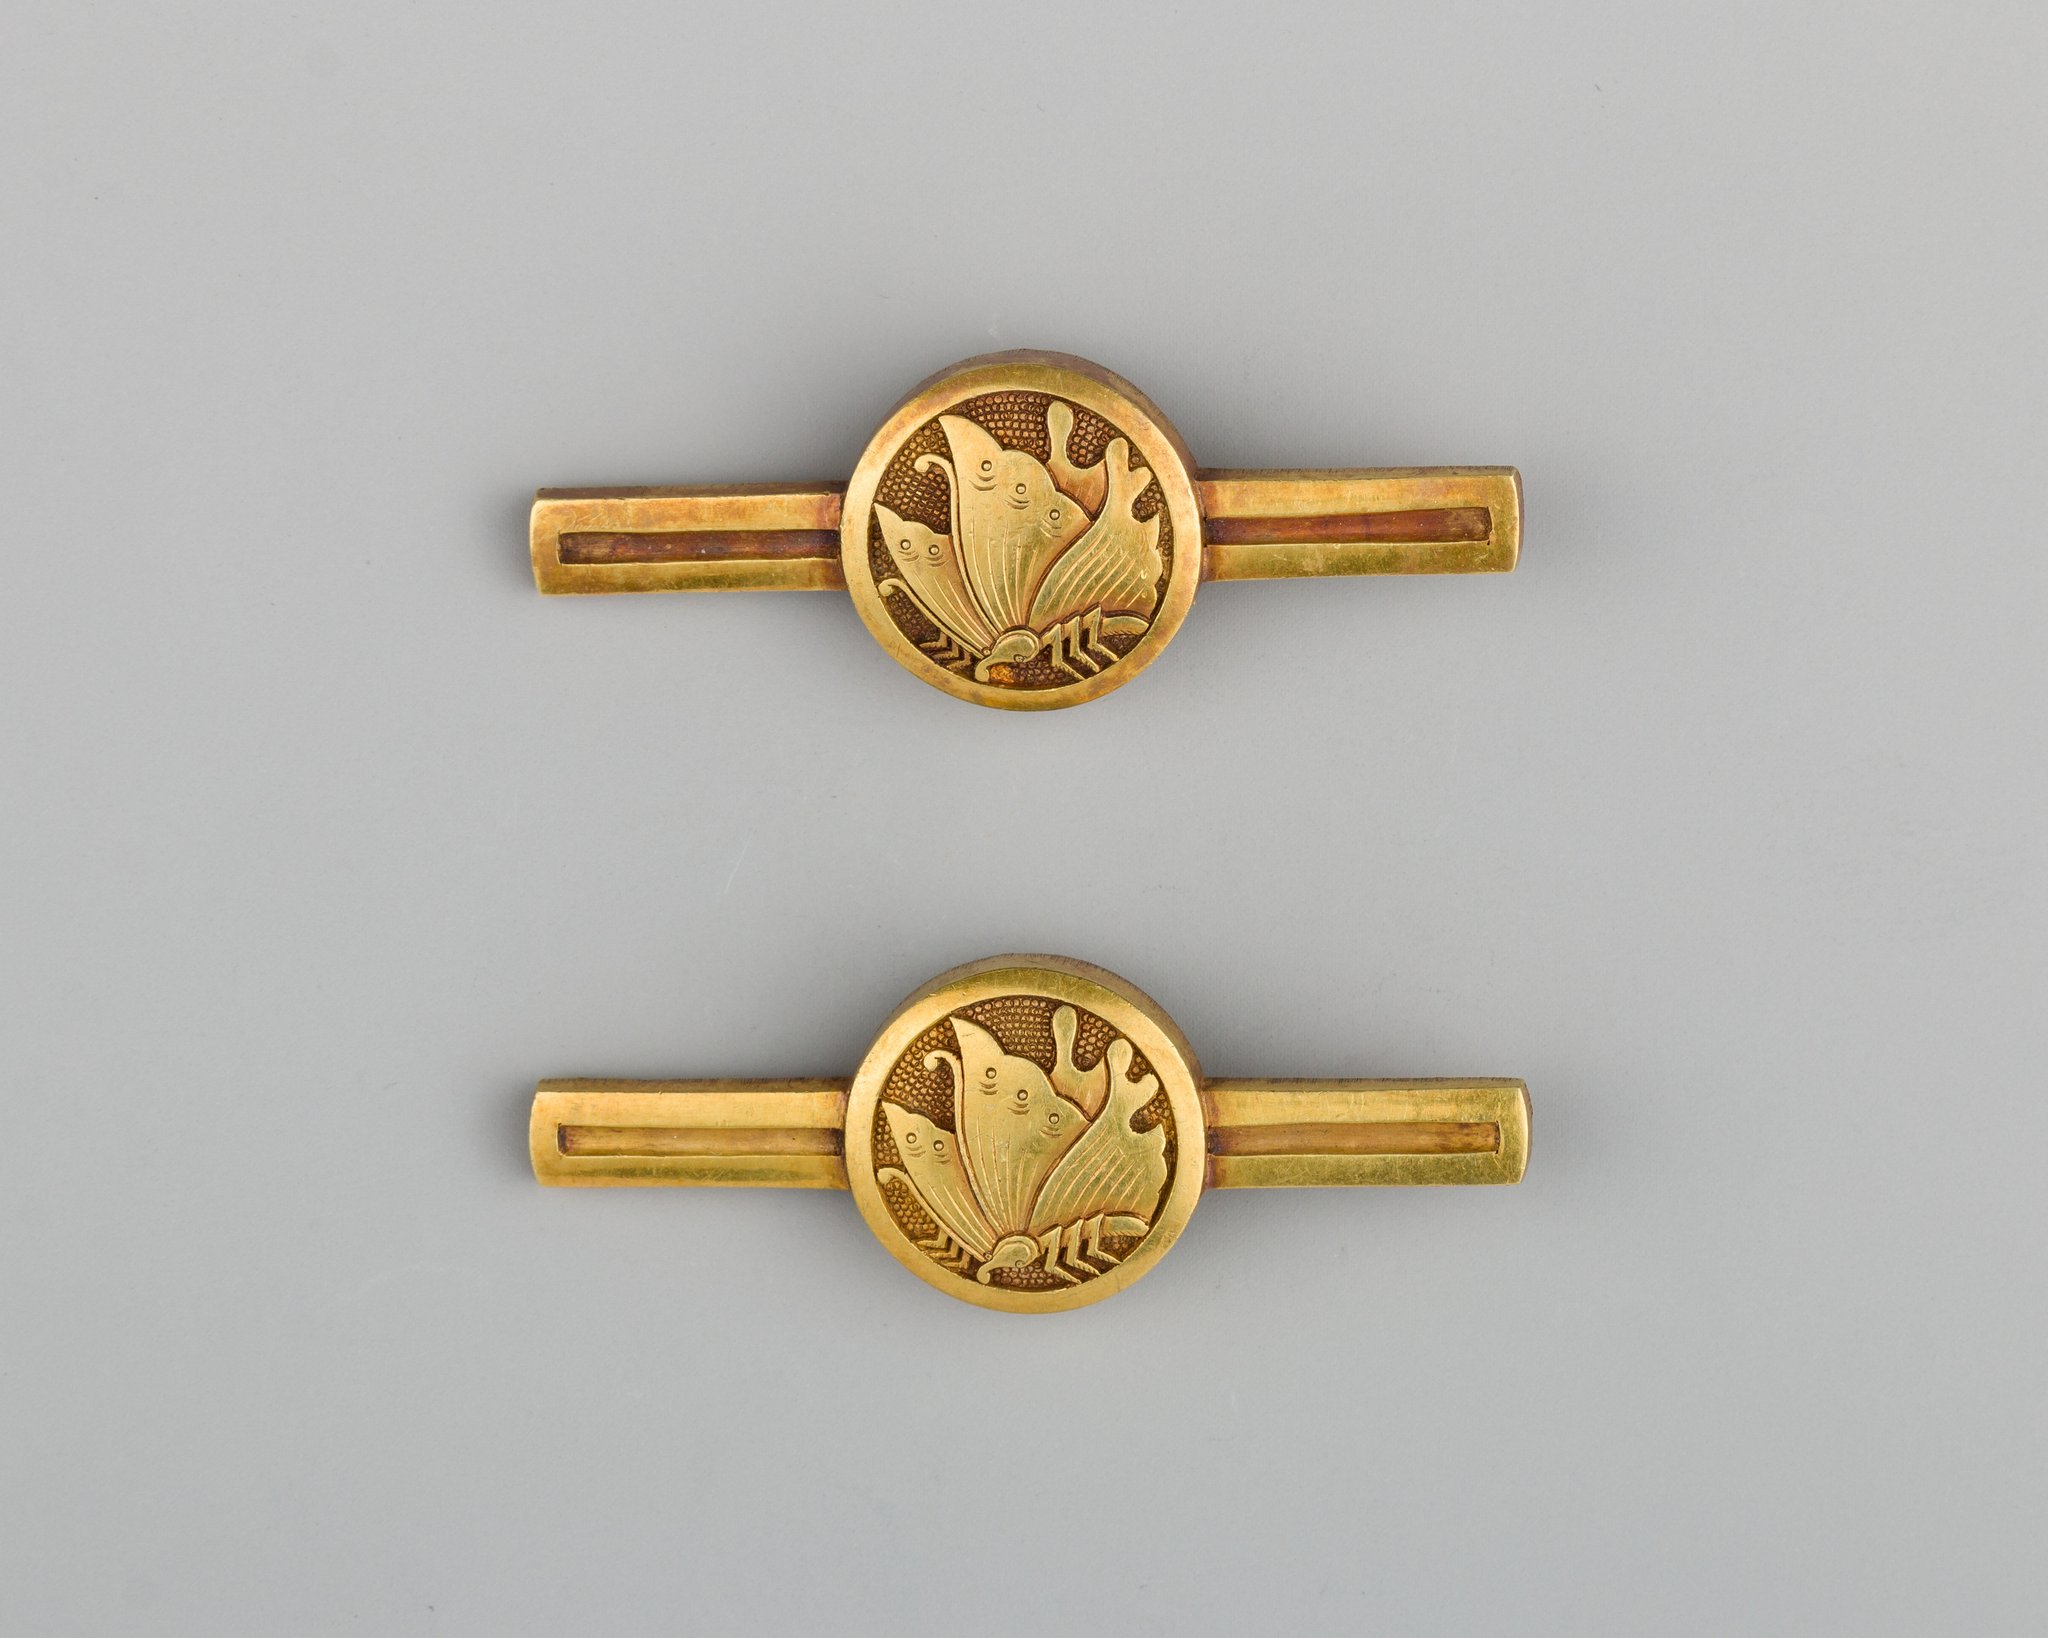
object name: pair of sword grip ornament menuki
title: Pair of Sword-Grip Ornaments (Menuki)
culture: japanese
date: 1701-1800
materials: copper, gold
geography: japan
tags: butterflies